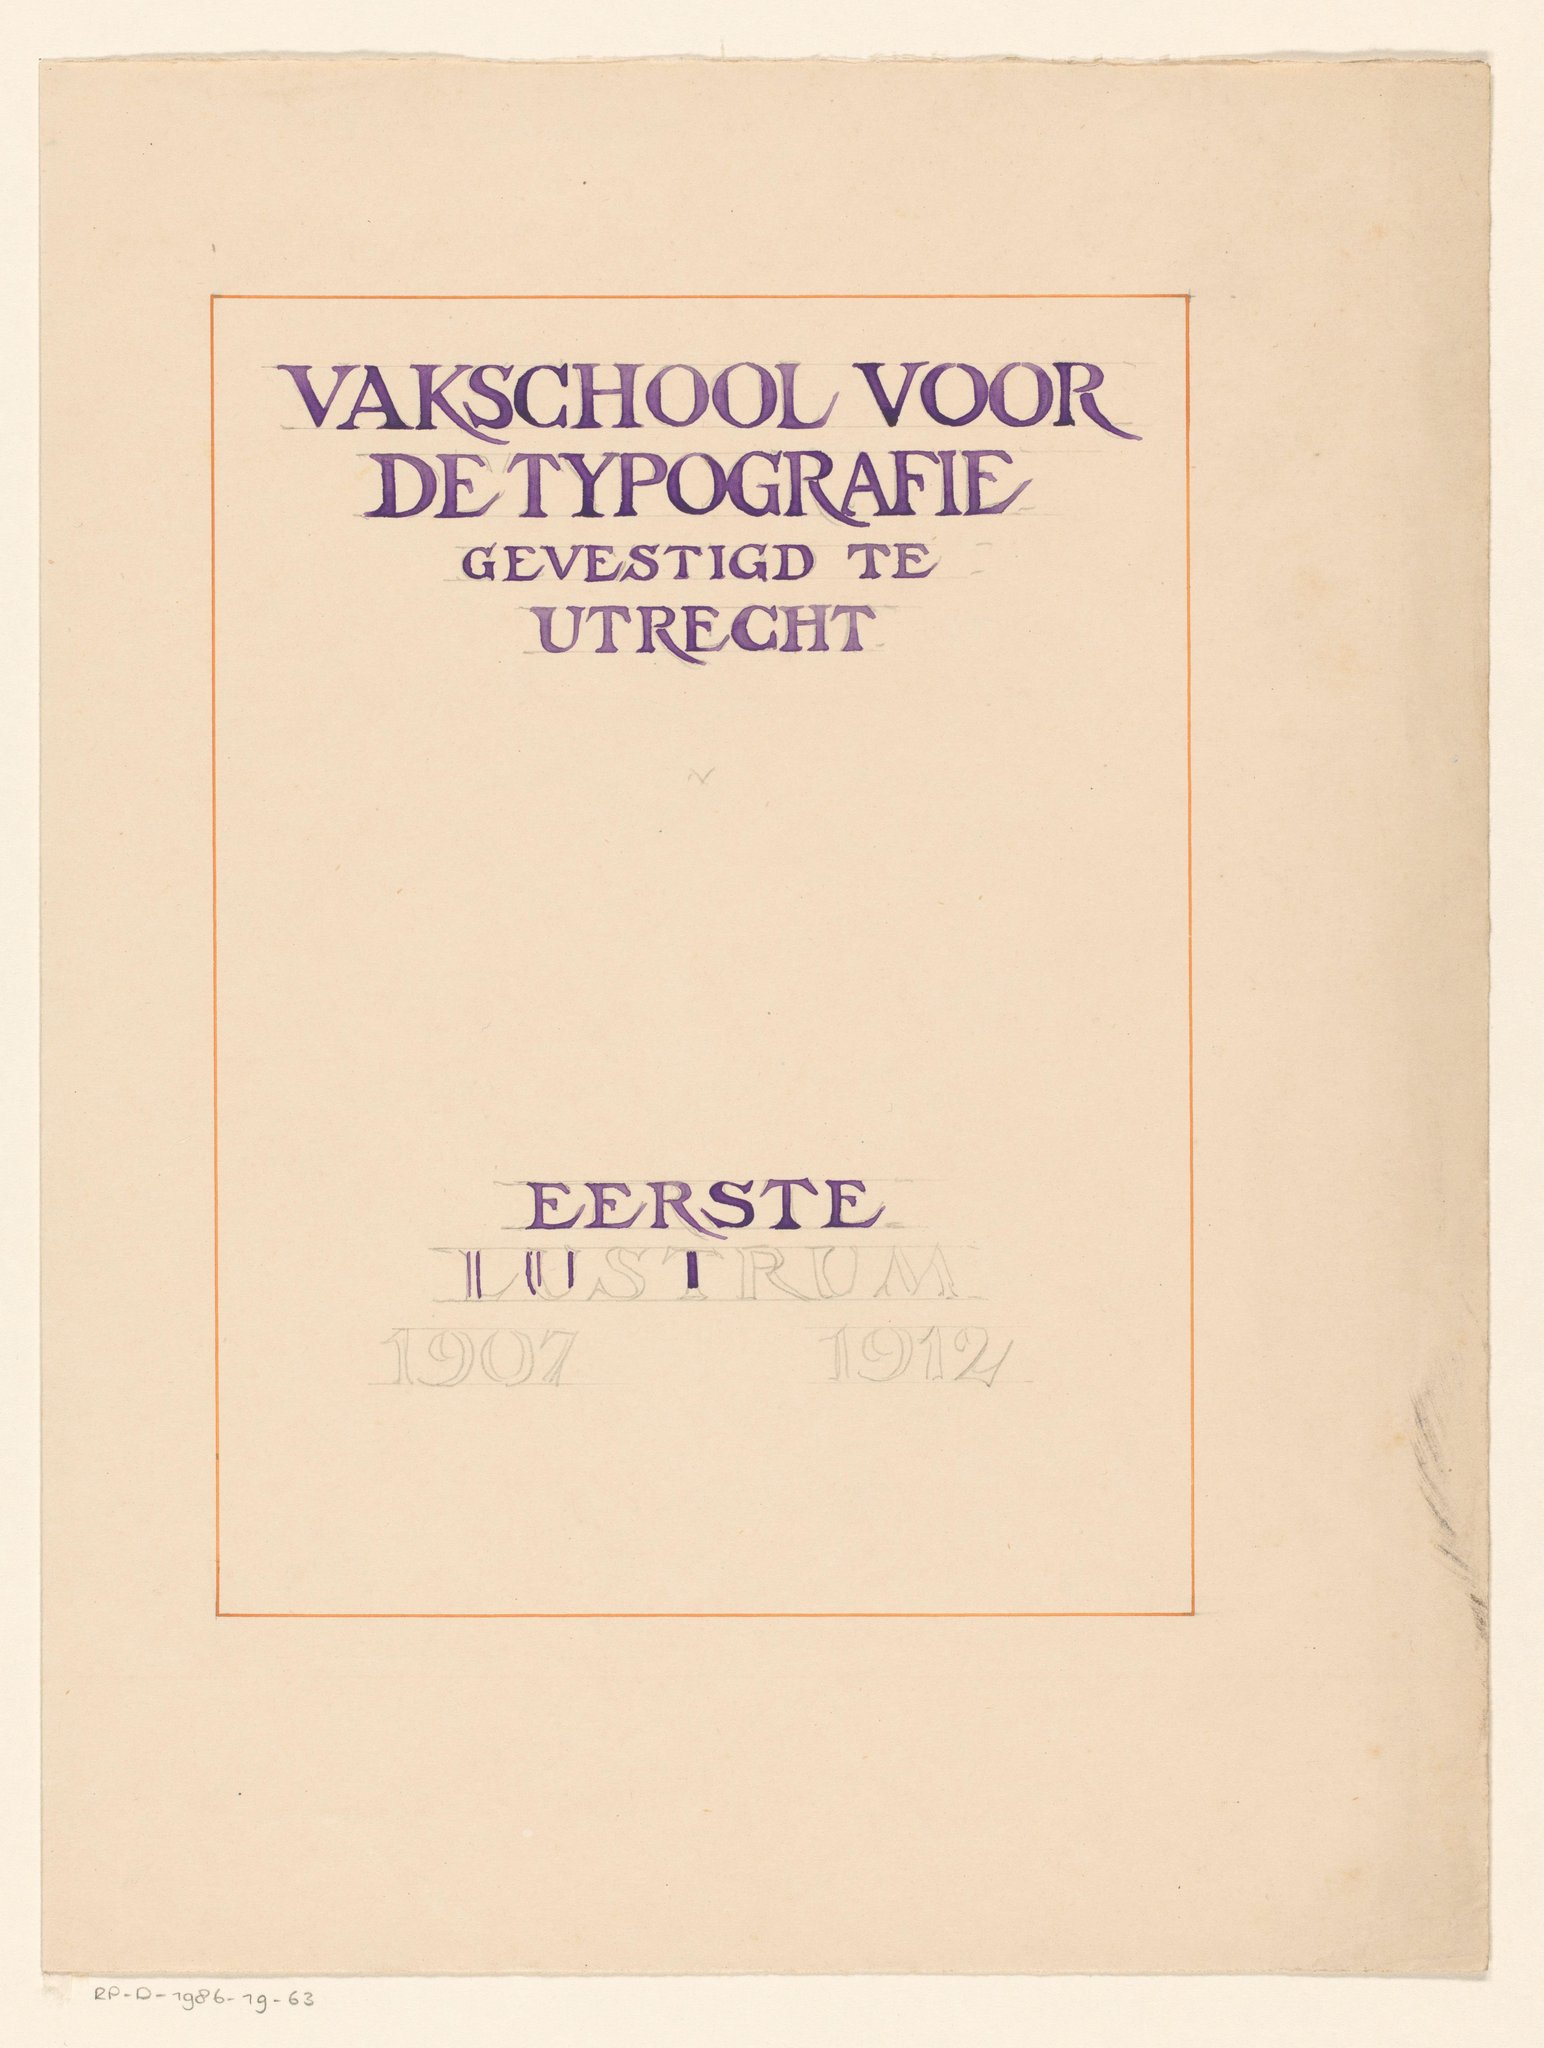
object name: drawing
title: Ontwerp voor het lustrumboek van de Vakschool voor de typografie te Utrecht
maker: reinier willem petrus de vries (1874-1953)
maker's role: draughtsman, print maker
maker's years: 1874-1953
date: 1912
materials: ink, paint, paper, pencil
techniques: brush, pen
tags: vakschool voor de typografie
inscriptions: collector's mark: ‘R:MVS.’